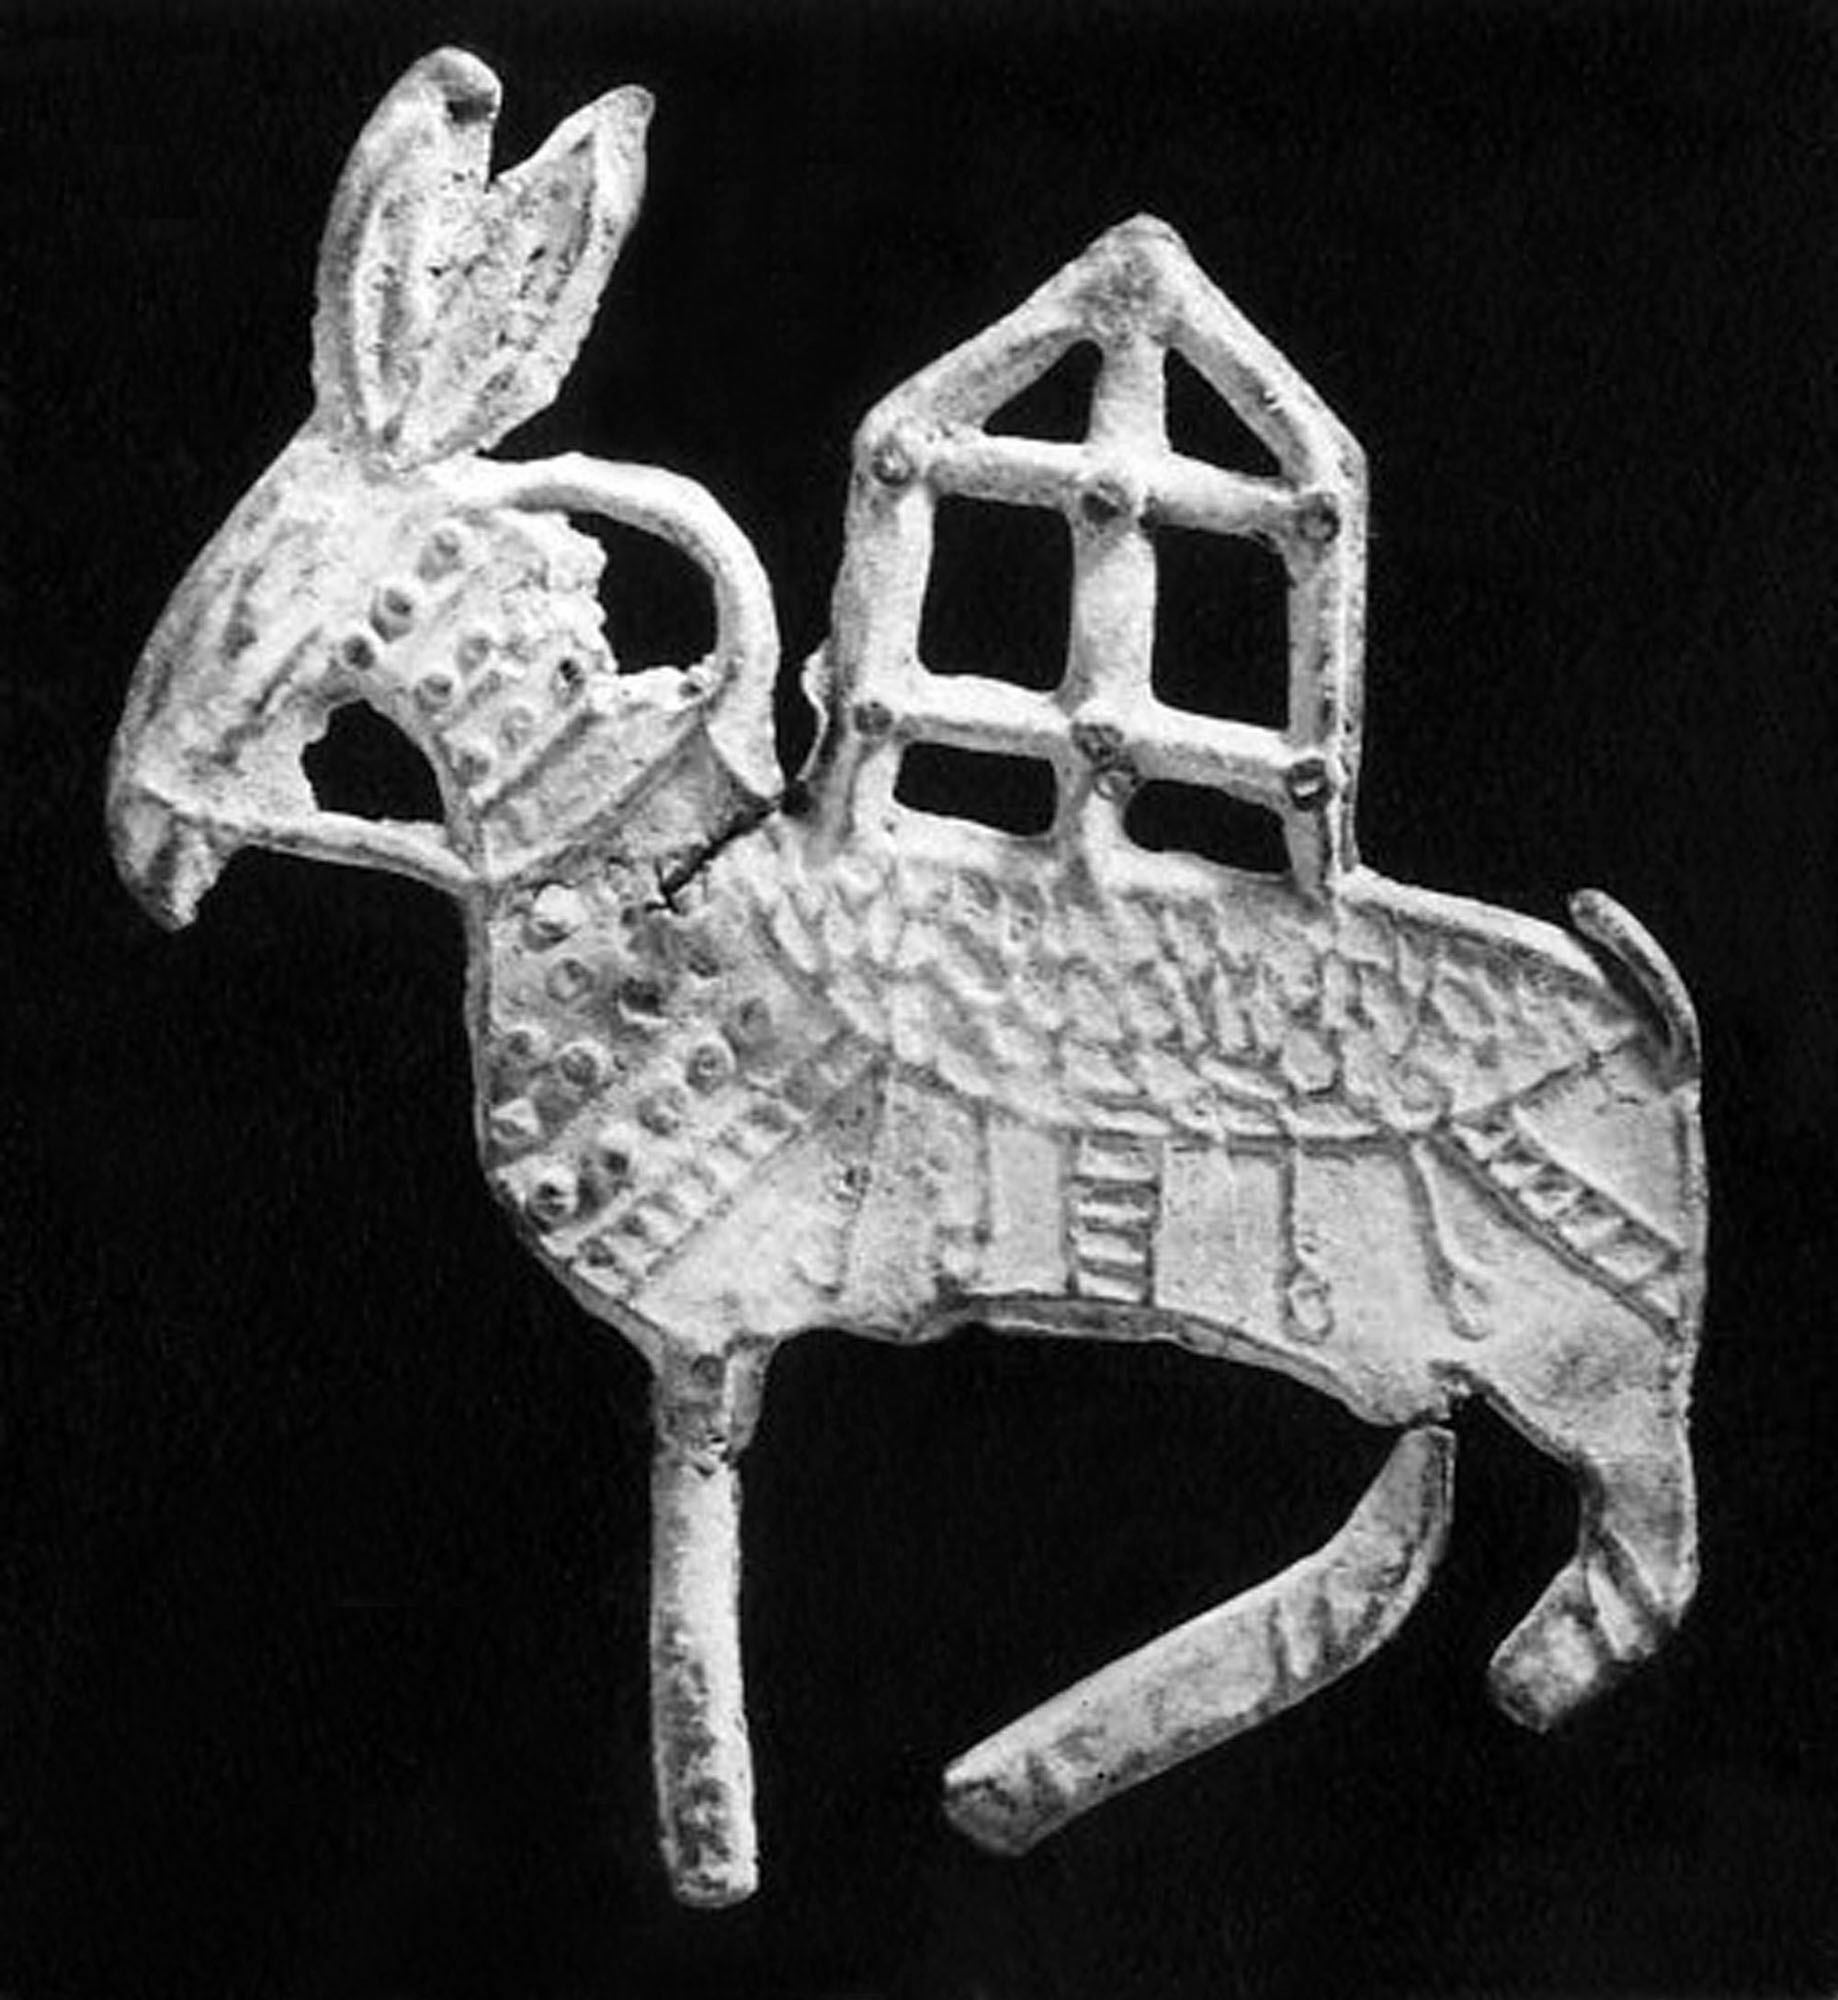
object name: plaque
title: Plaque in the shape of a donkey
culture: chinese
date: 201-600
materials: lead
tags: donkeys